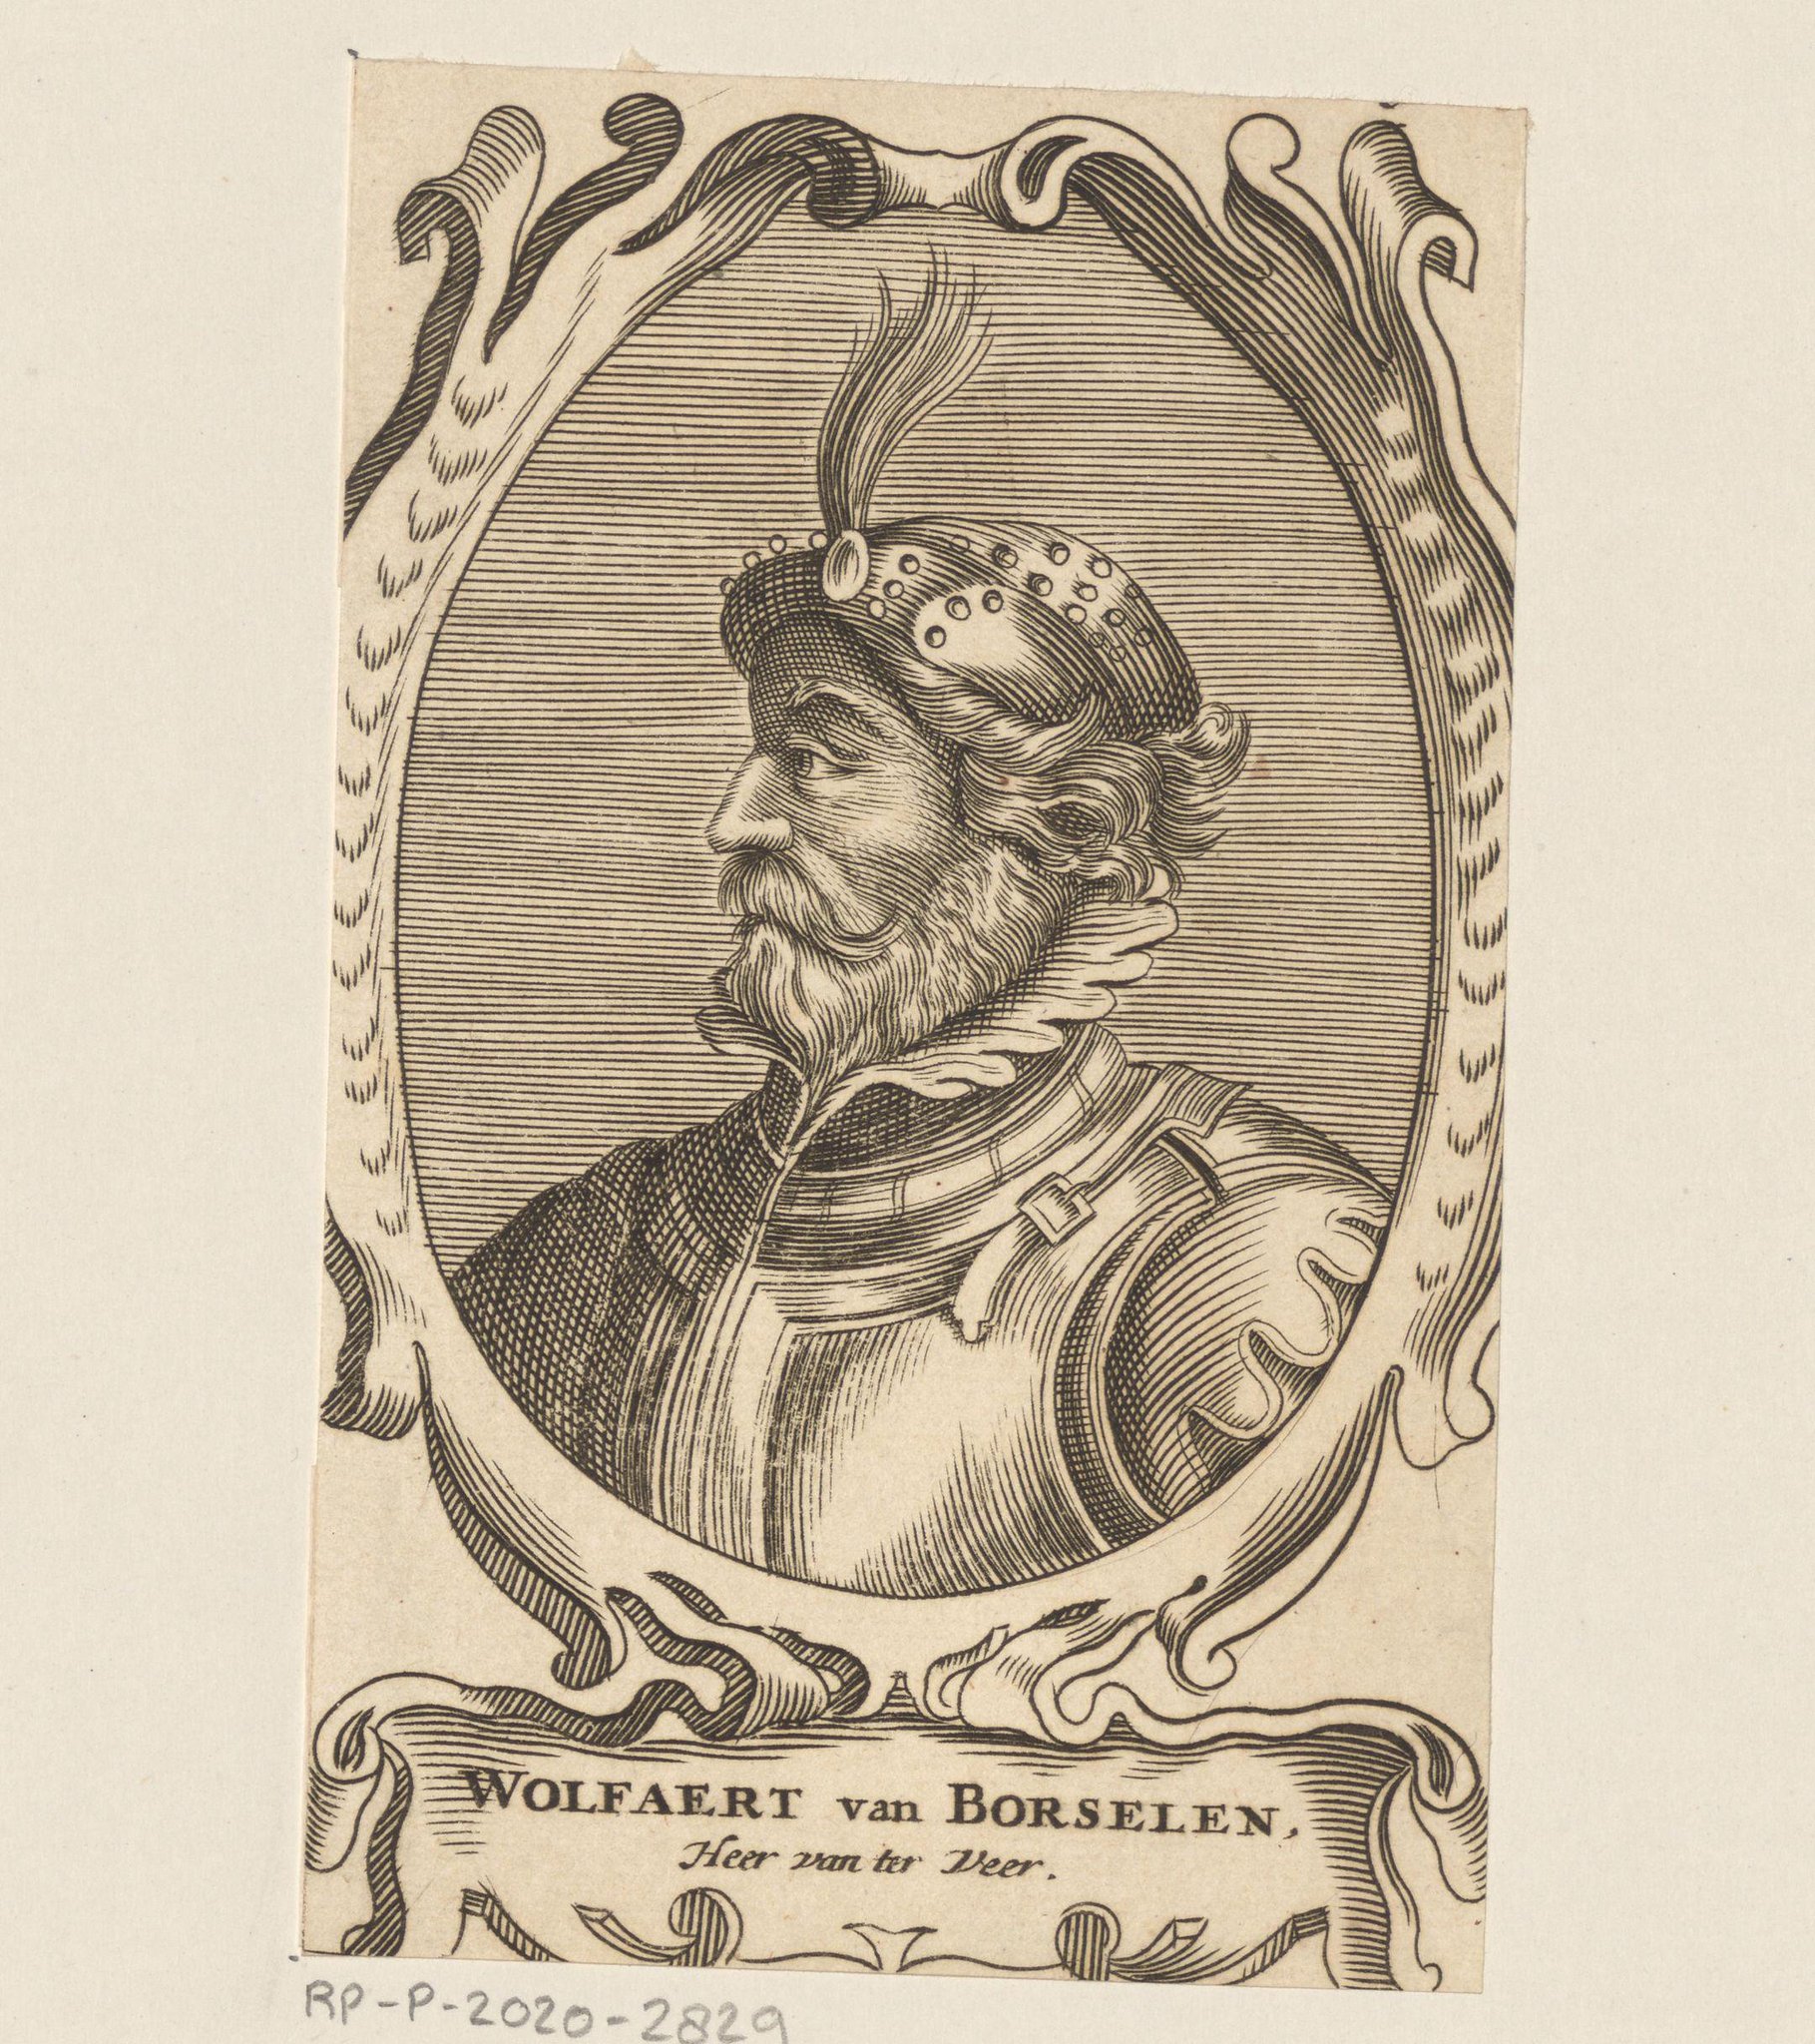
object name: print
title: Portret van Wolfert van Borselen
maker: Anonymous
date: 1650-1699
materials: paper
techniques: engraving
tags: delft, historical persons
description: Prent waarschijnlijk afkomstig uit een van de werken van Lambert van den Bos.